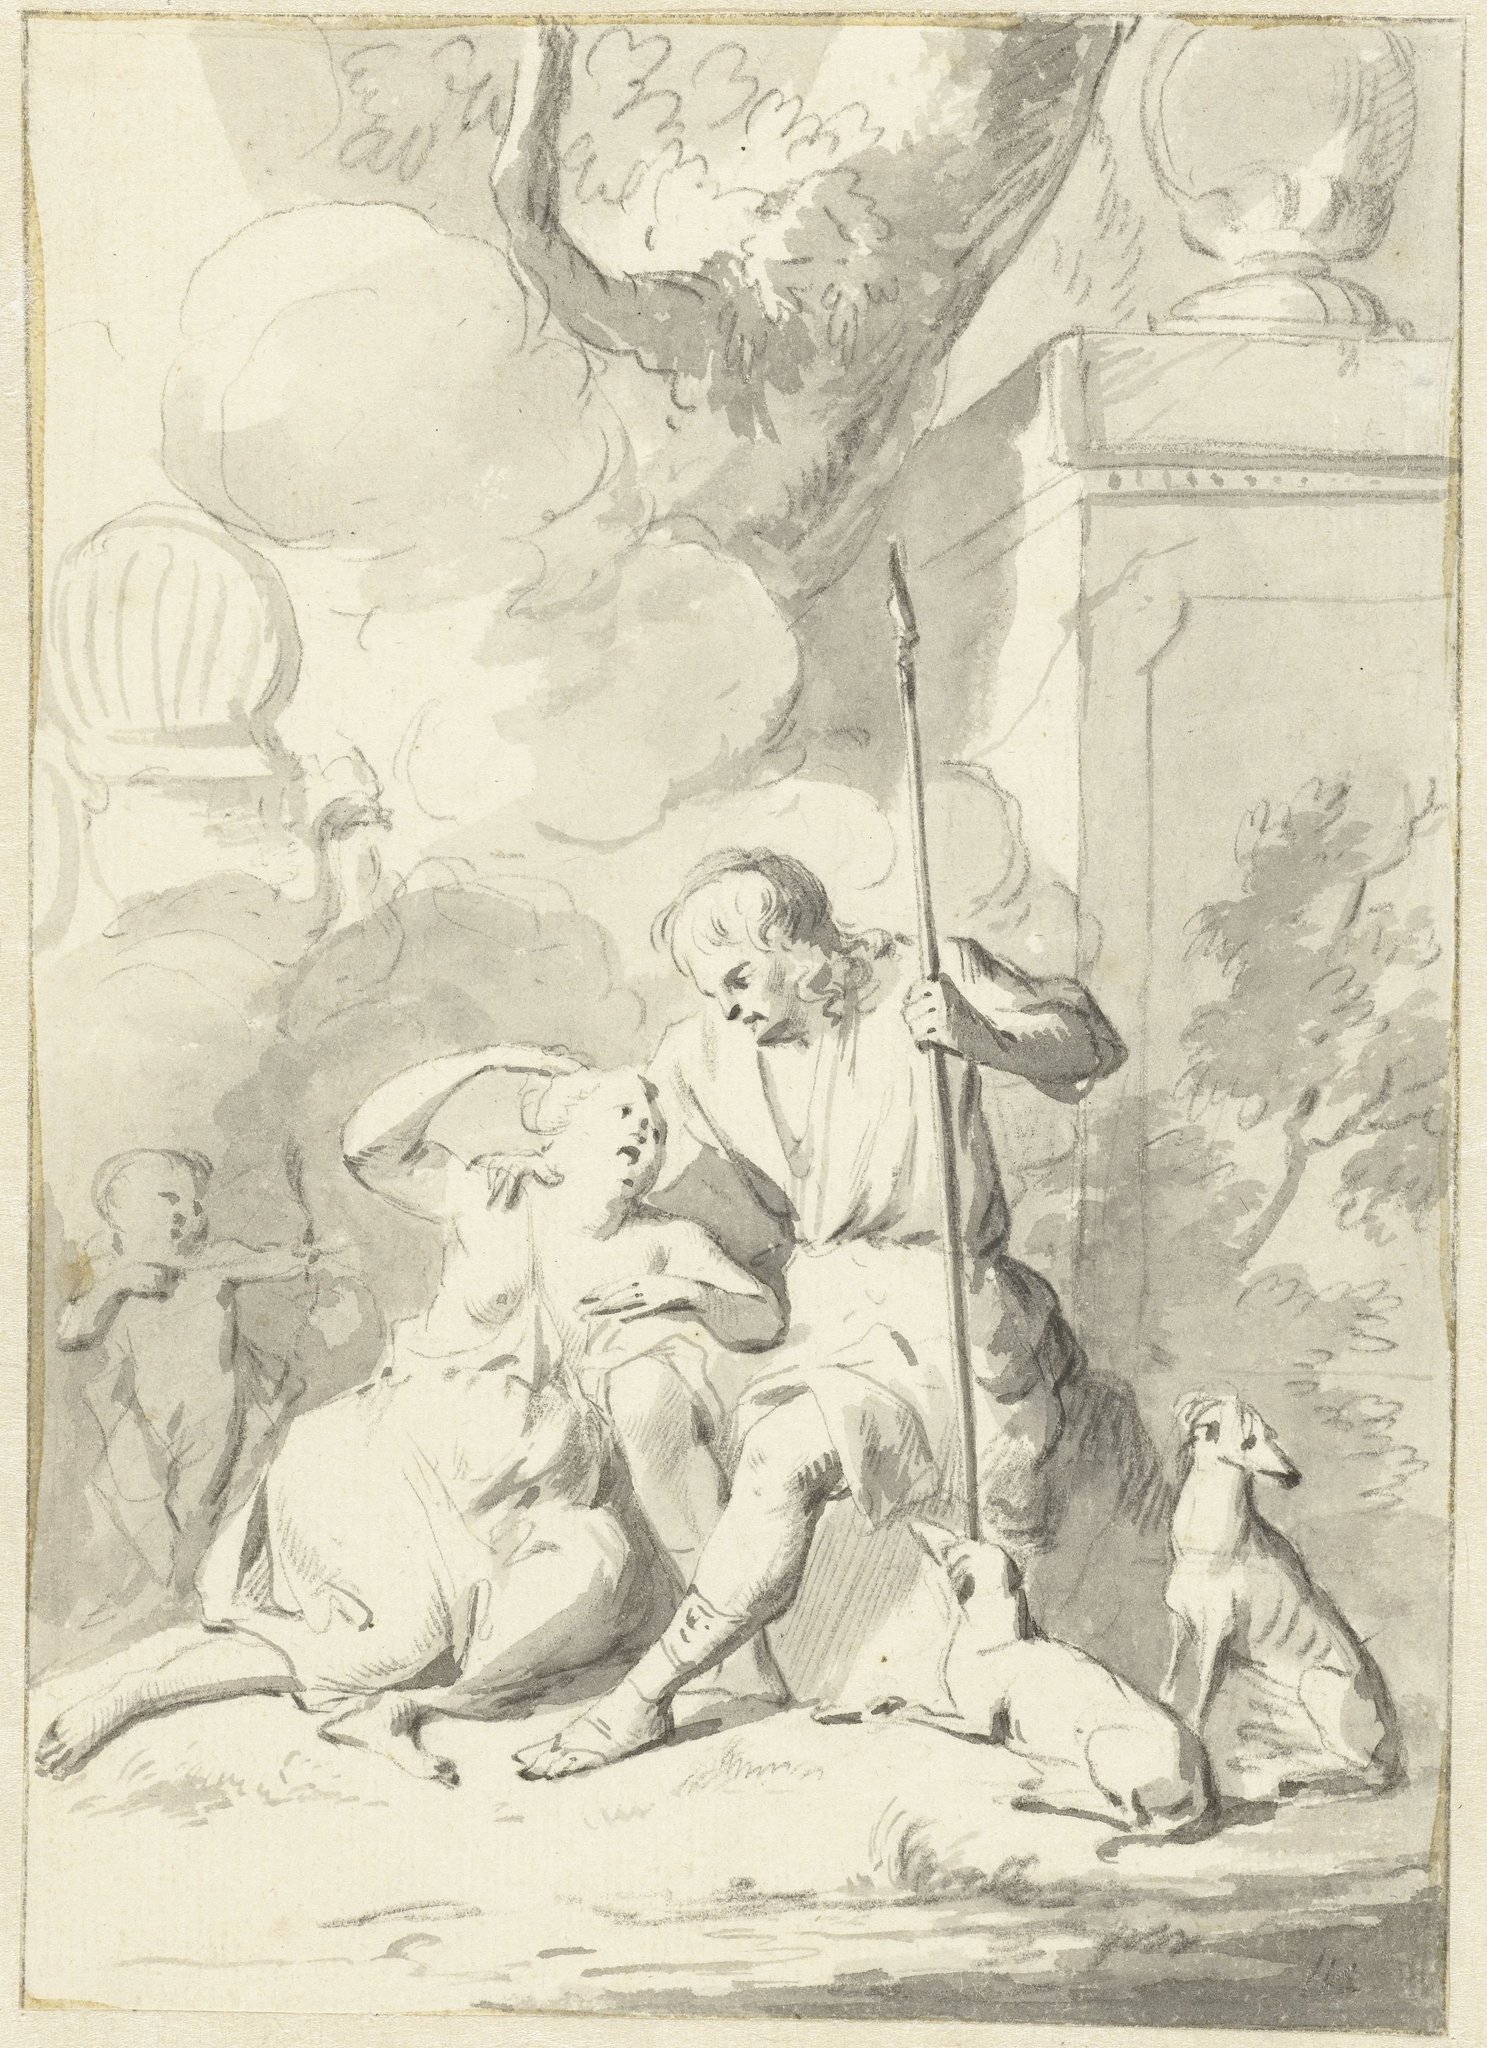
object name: drawing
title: Venus en Adonis (?)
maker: aert schouman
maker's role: draughtsman, painter, print maker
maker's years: 1710-1792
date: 1720-1792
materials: chalk, ink, paper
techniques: brush, pen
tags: venus trying to prevent adonis from going hunting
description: Links een cupido met boog; rechts jachthonden.